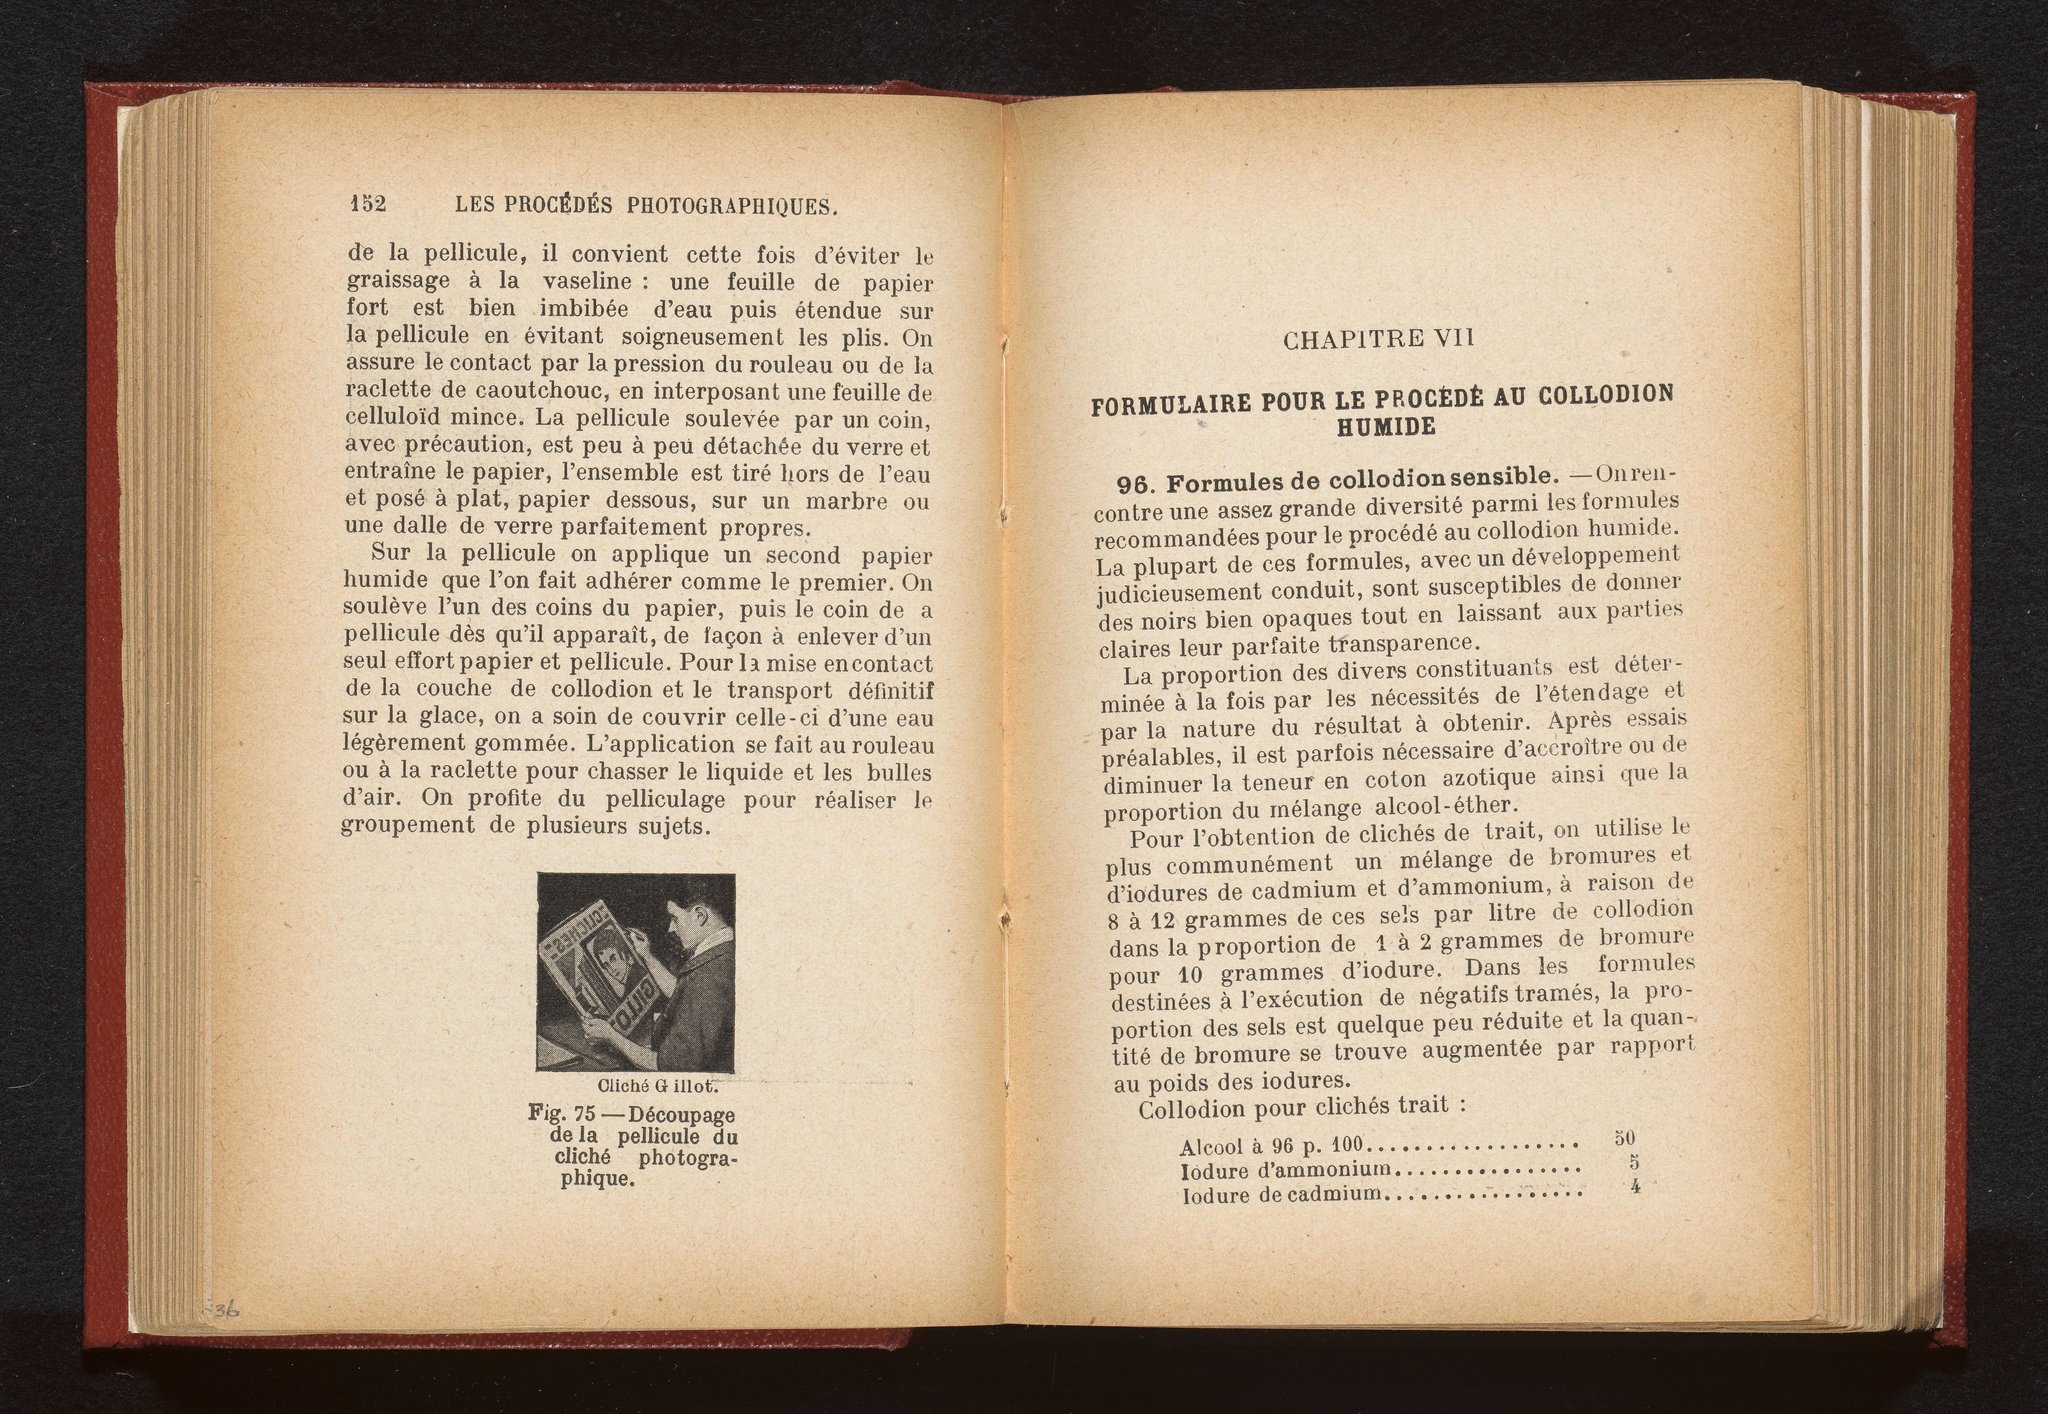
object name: photomechanical print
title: Man die een fotografische opname afwerkt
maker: Anonymous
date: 1922-1932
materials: paper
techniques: autotype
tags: photographic apparatus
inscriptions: number: ‘Fig. 75’